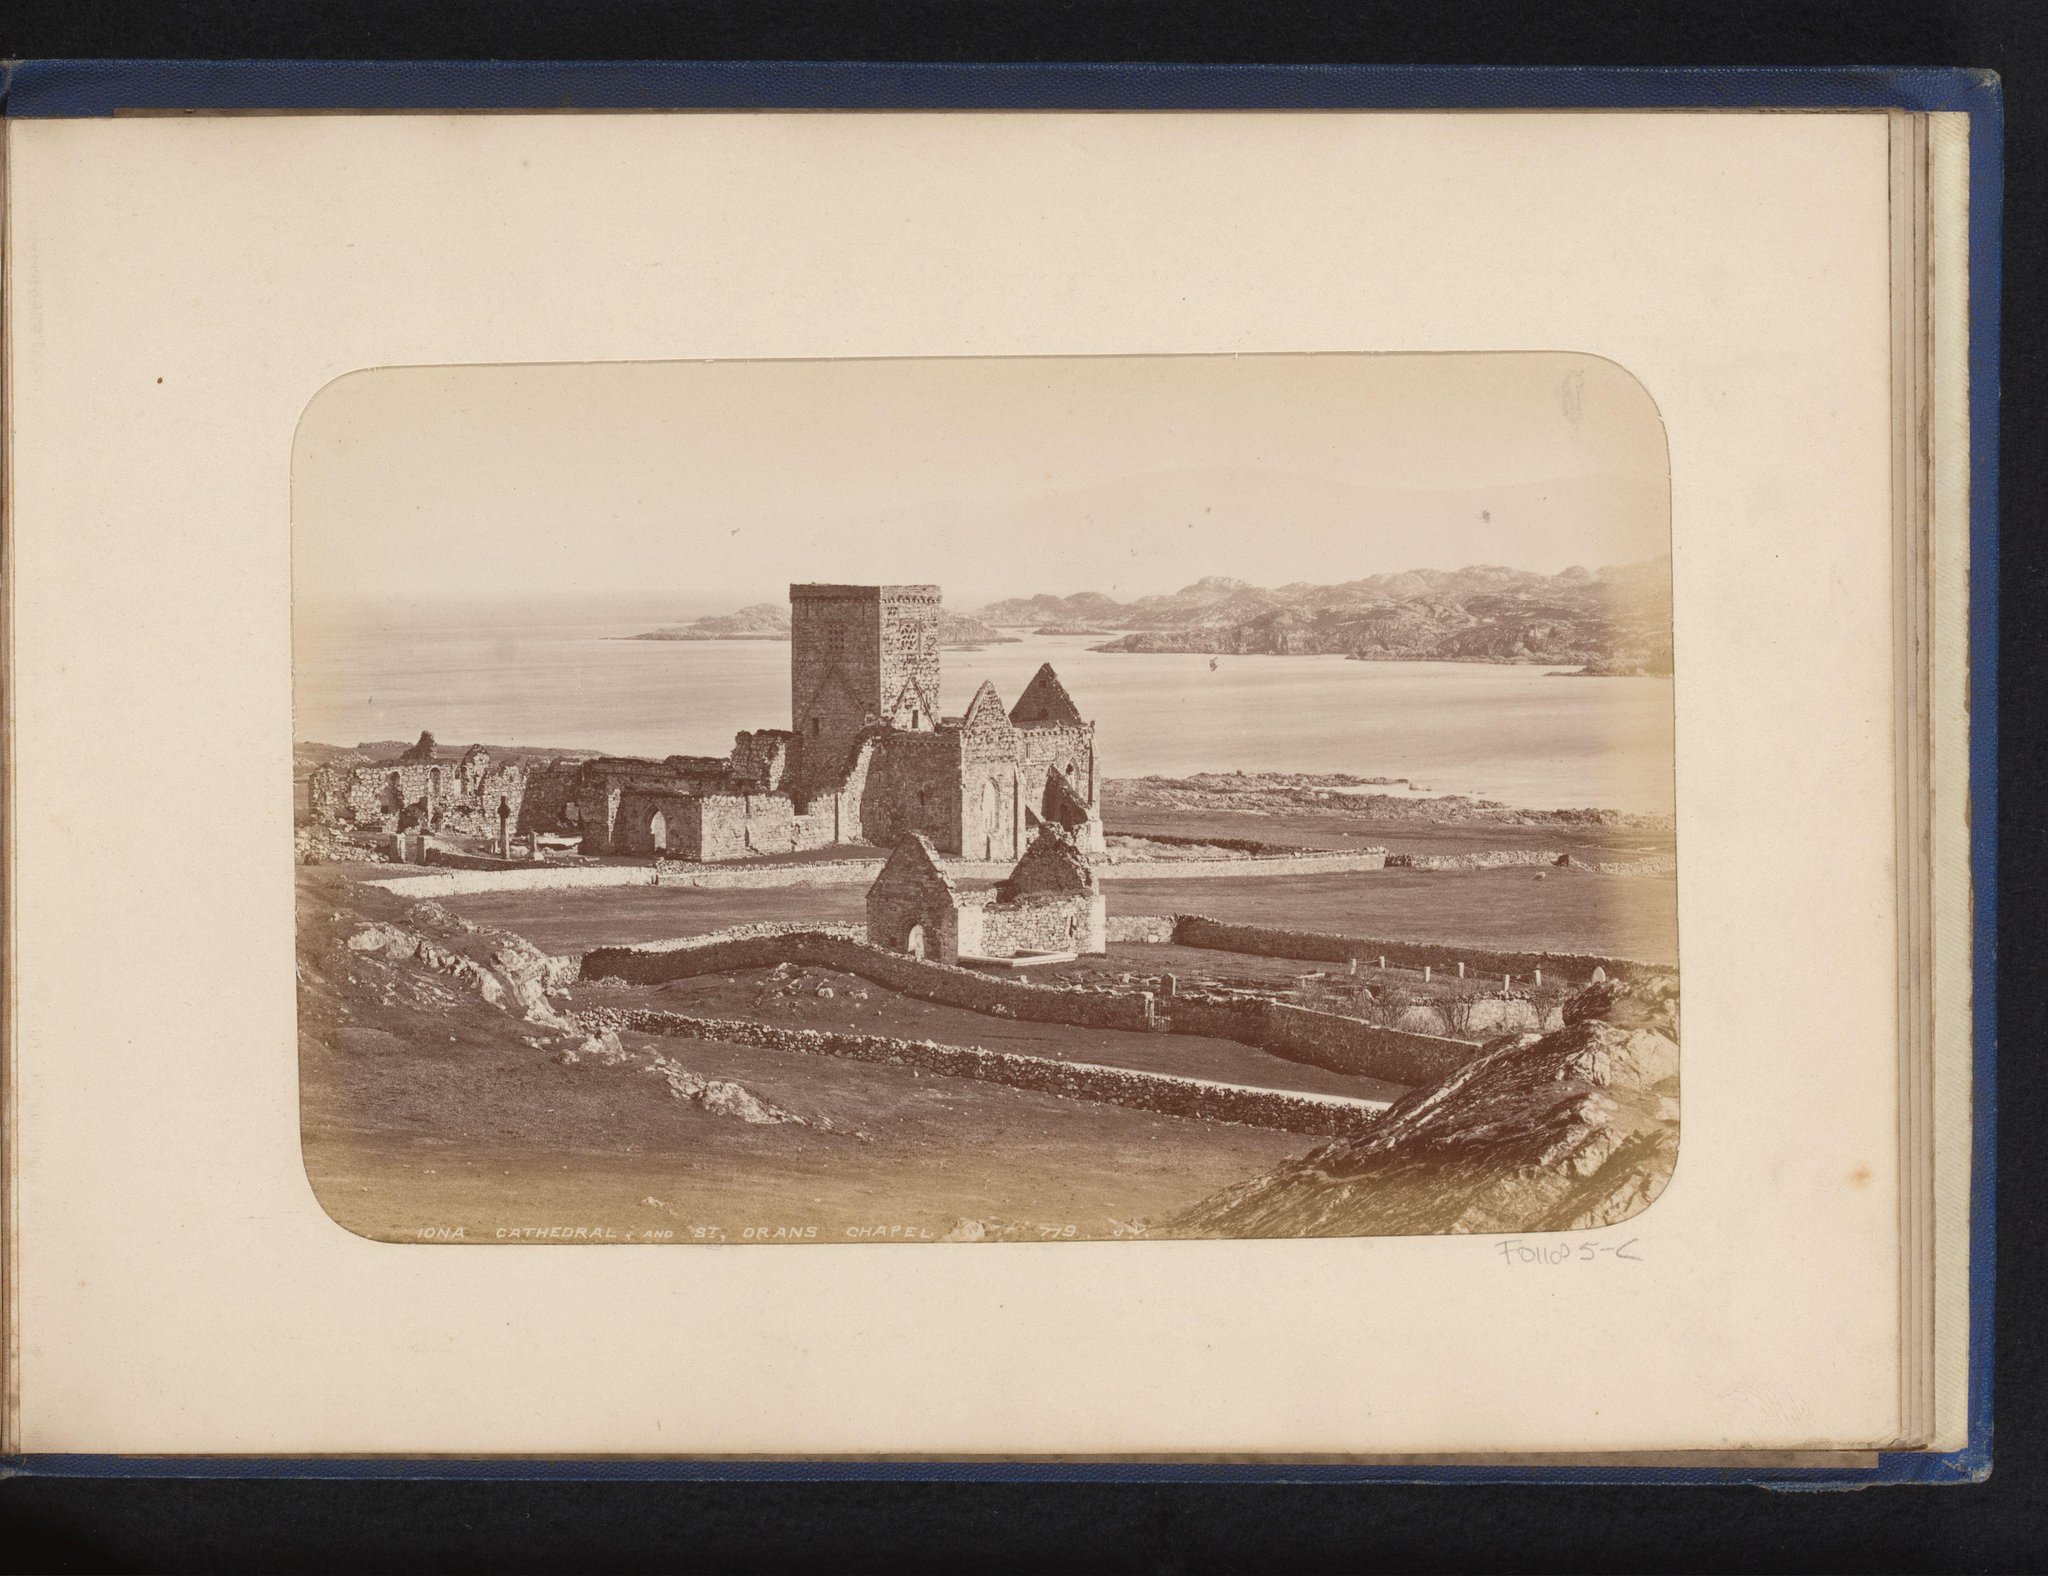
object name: photograph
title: Gezicht op Iona Abbey en St. Oran's chapel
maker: james valentine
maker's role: fotograaf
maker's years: 1815-1880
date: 1865-1875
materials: photographic support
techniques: albumen print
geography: iona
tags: landscape with ruins, ruin of church, monastery, etc.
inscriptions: inscription: ‘Iona cathedral, and St. Orans Chapel 779. J.V.’